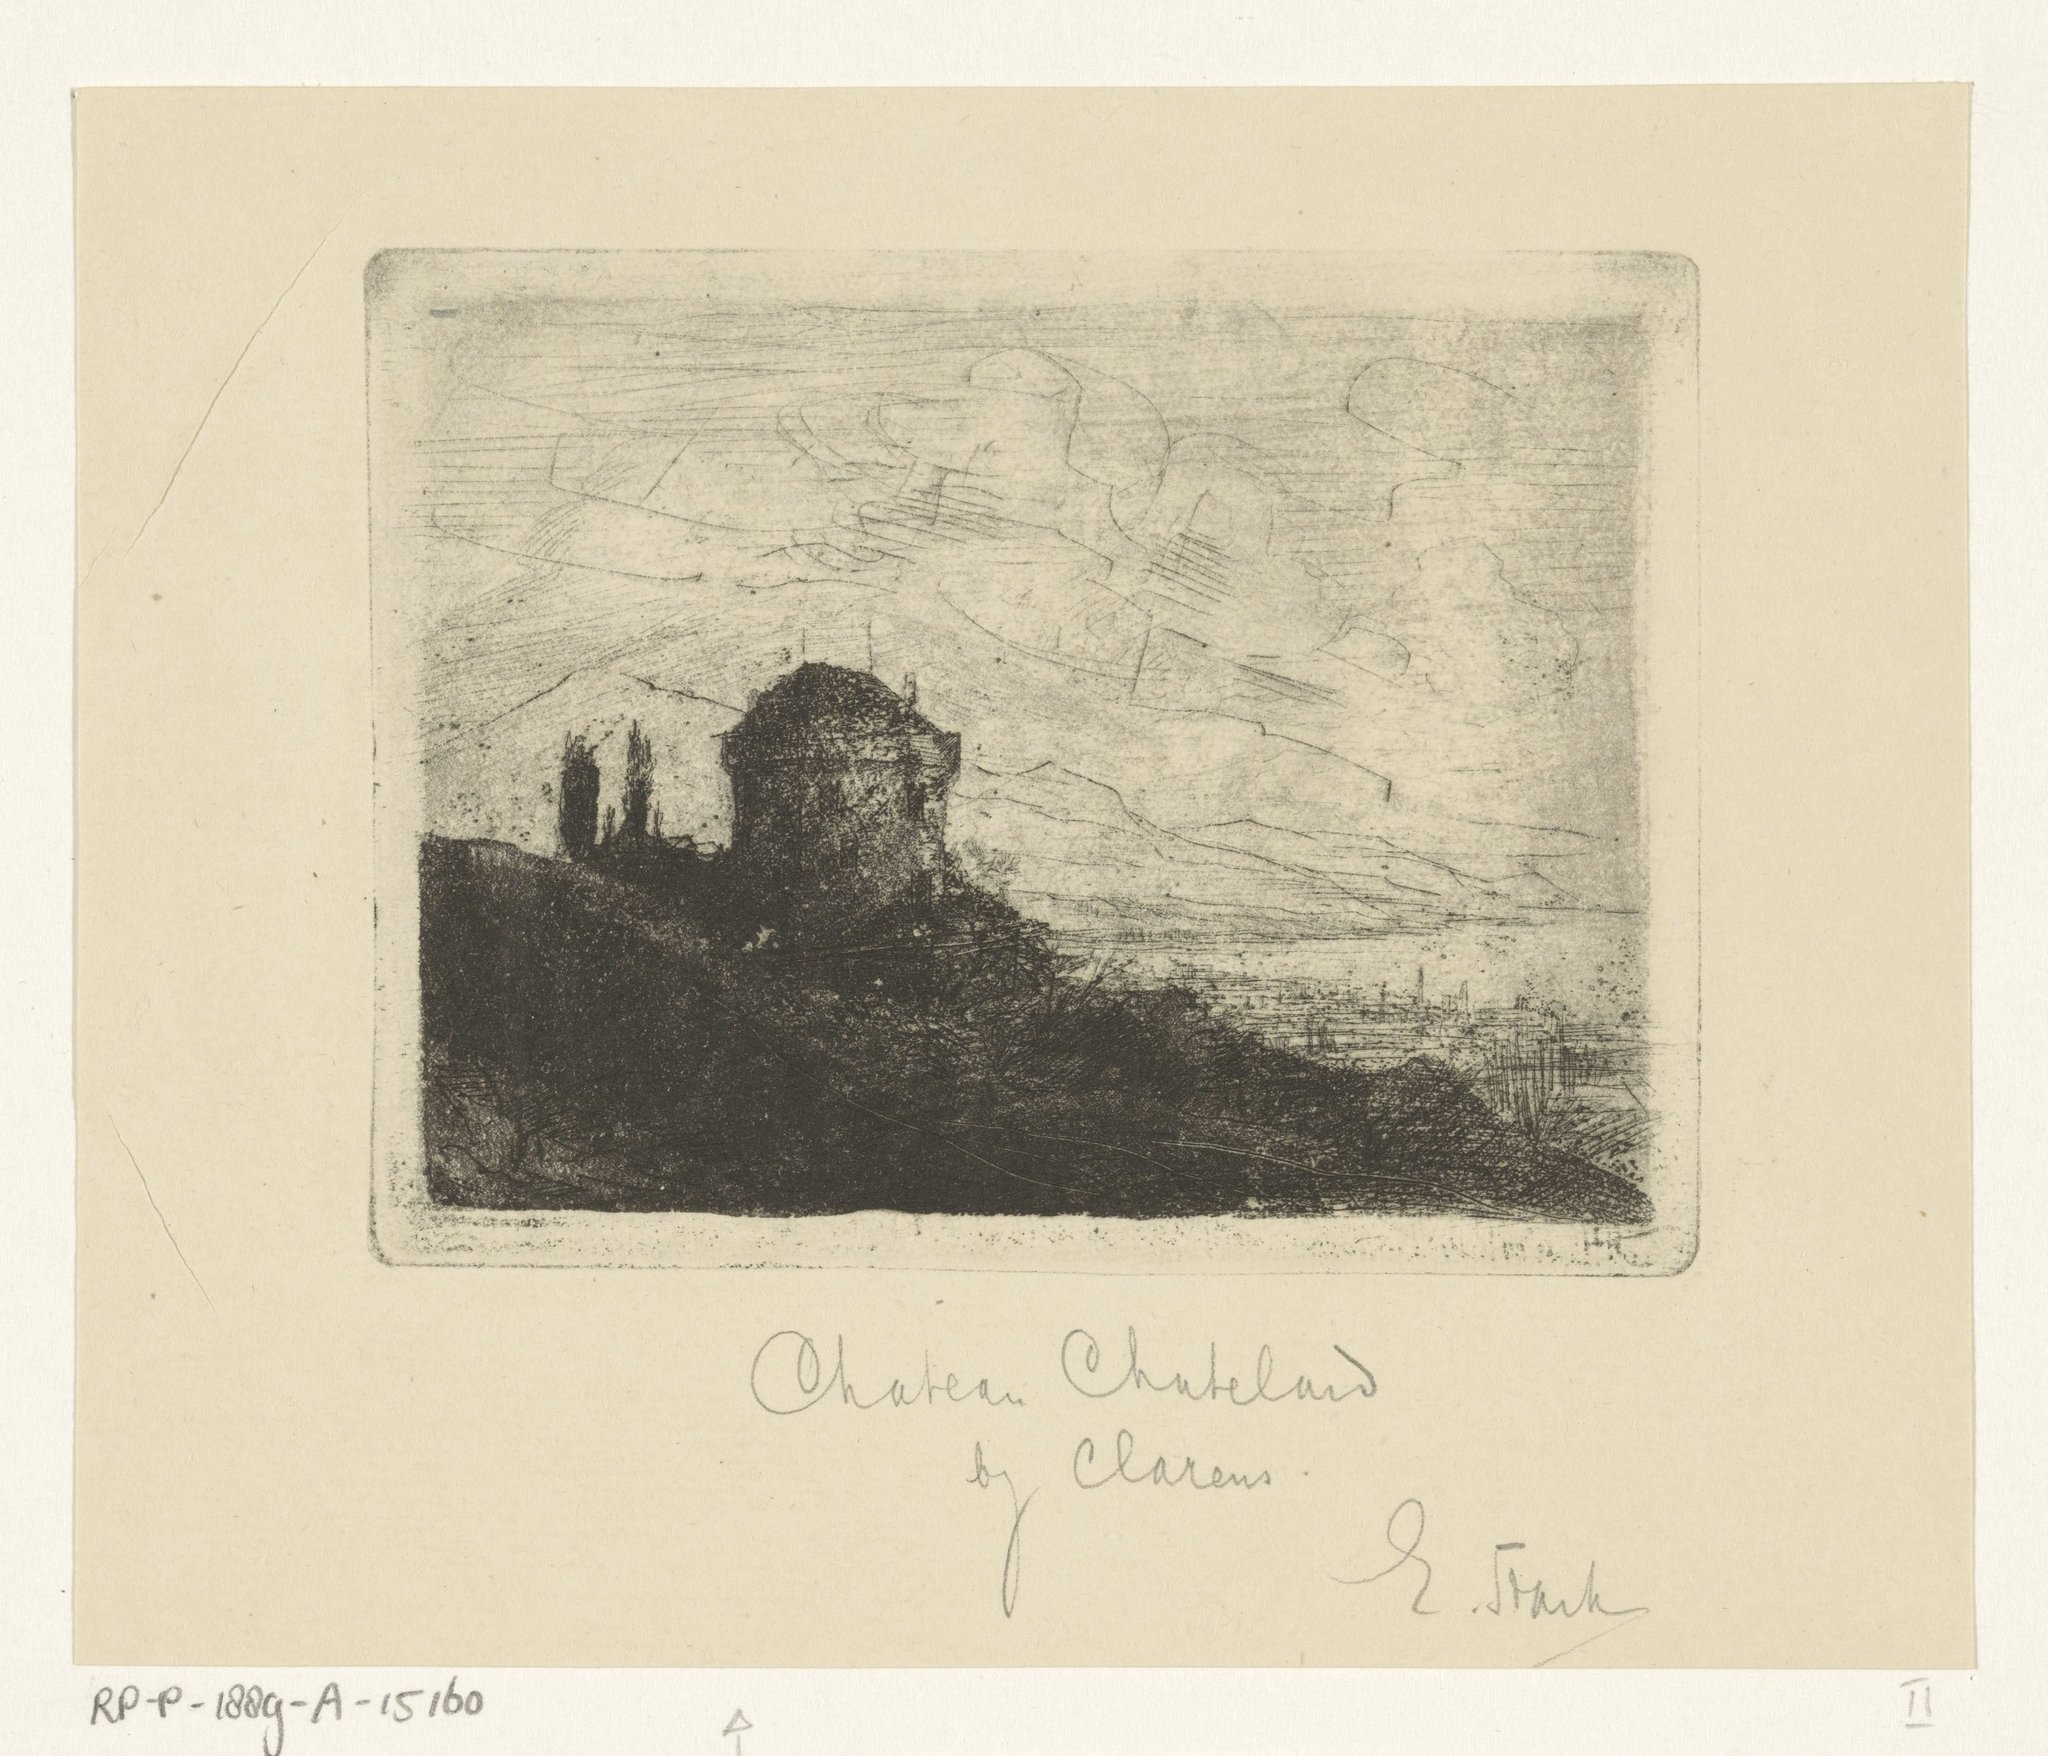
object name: print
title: Kasteel Chatelard bij Clarens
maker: elias stark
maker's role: draughtsman, print maker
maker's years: 1849-1933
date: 1802-1888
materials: paper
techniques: aquatint, drypoint, etching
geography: france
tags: castle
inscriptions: collector's mark: Lugt 2228